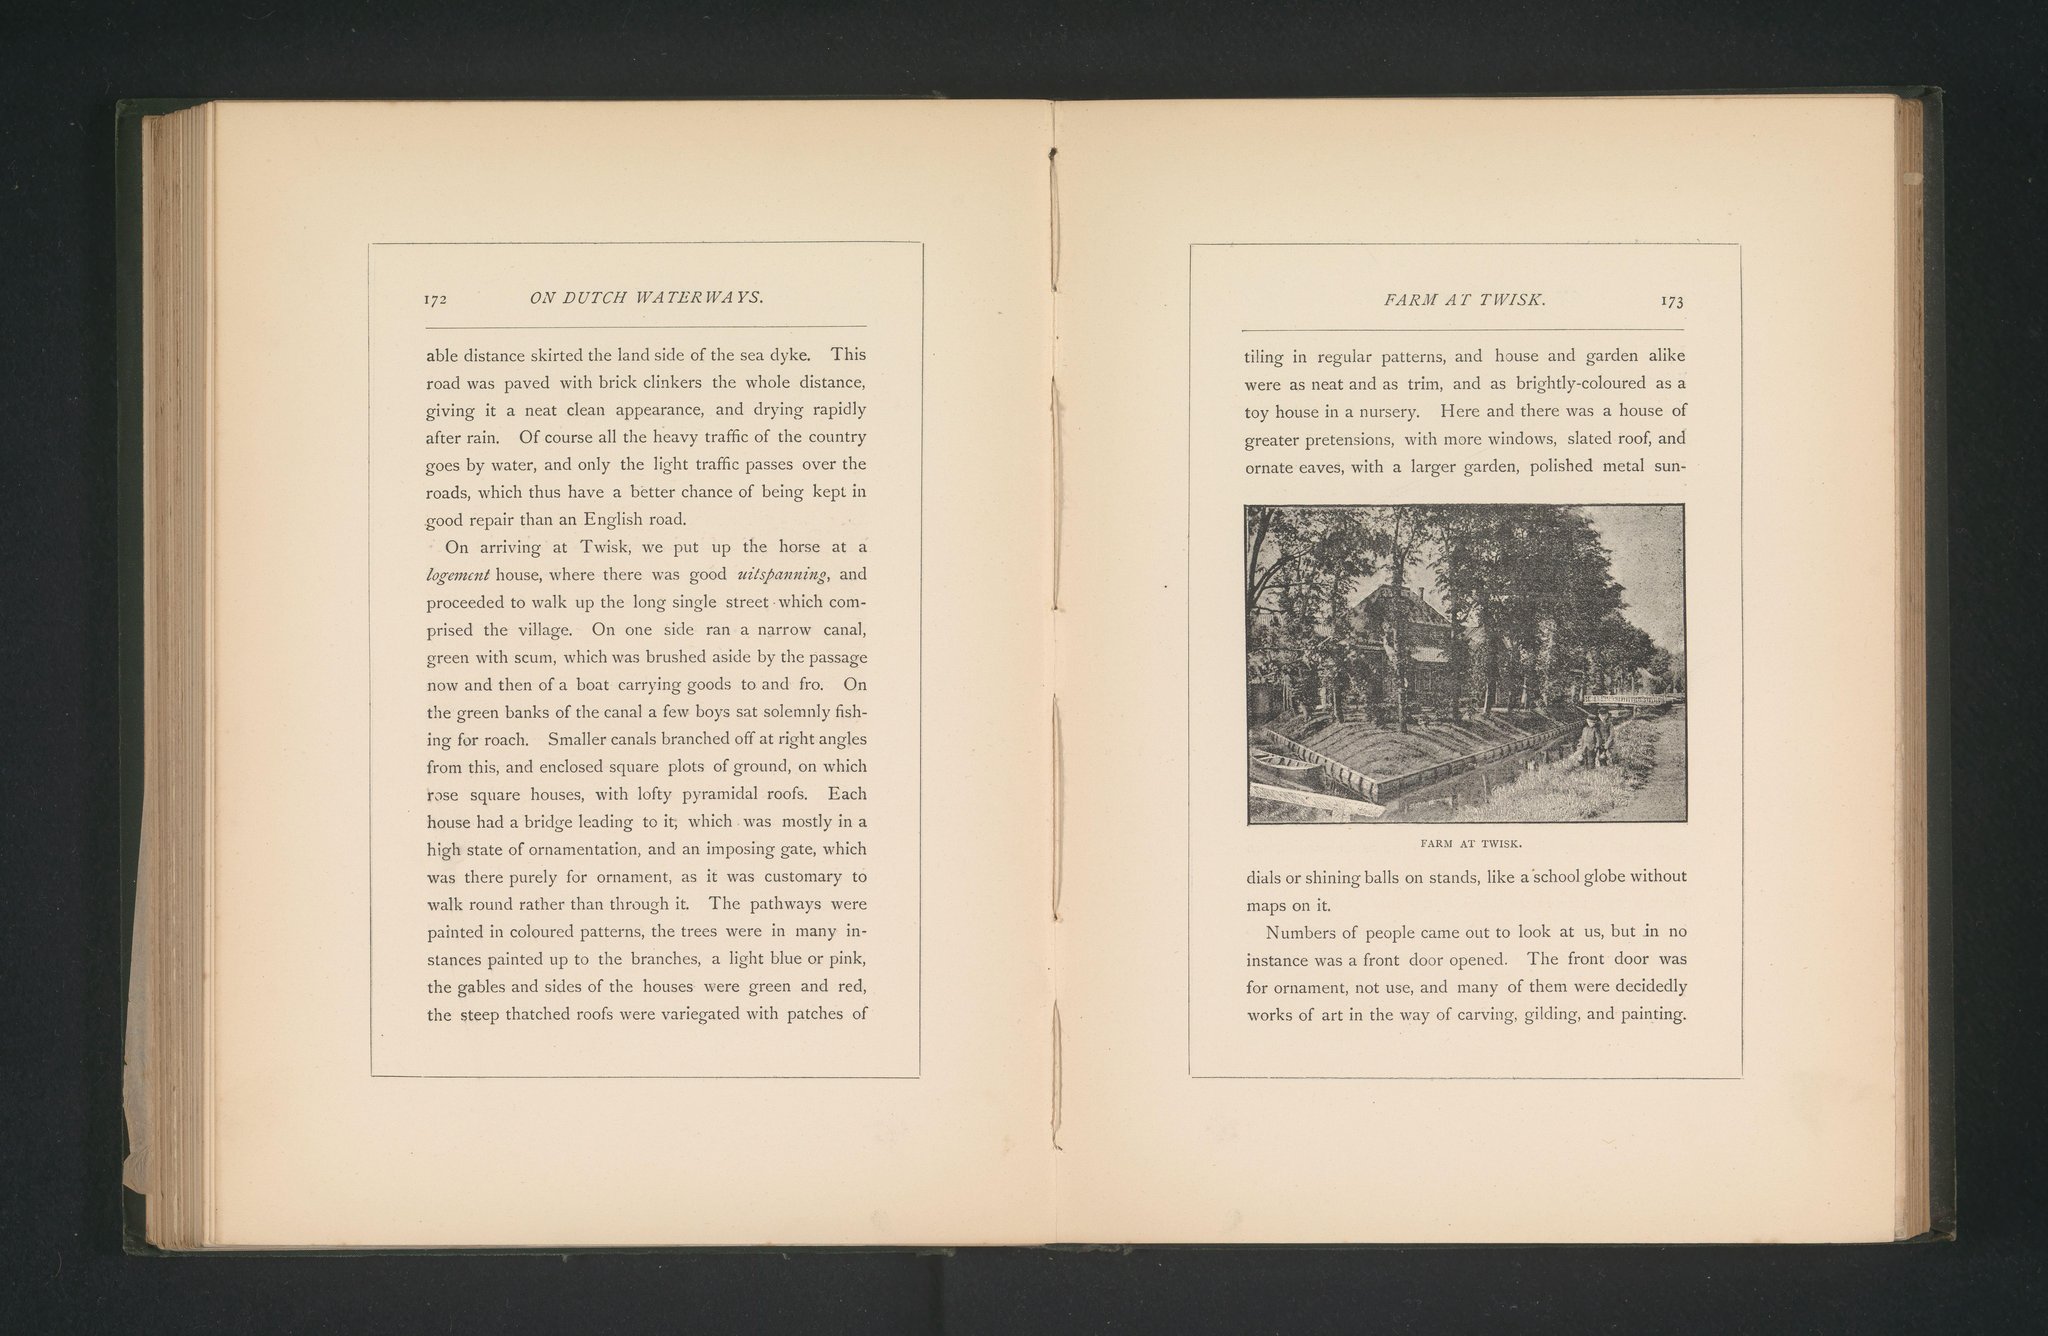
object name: page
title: Farm at Twisk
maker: george christopher davies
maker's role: fotograaf, geoloog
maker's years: 1849-1922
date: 1881-1886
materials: paper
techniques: autotype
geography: twisk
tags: farm (building)